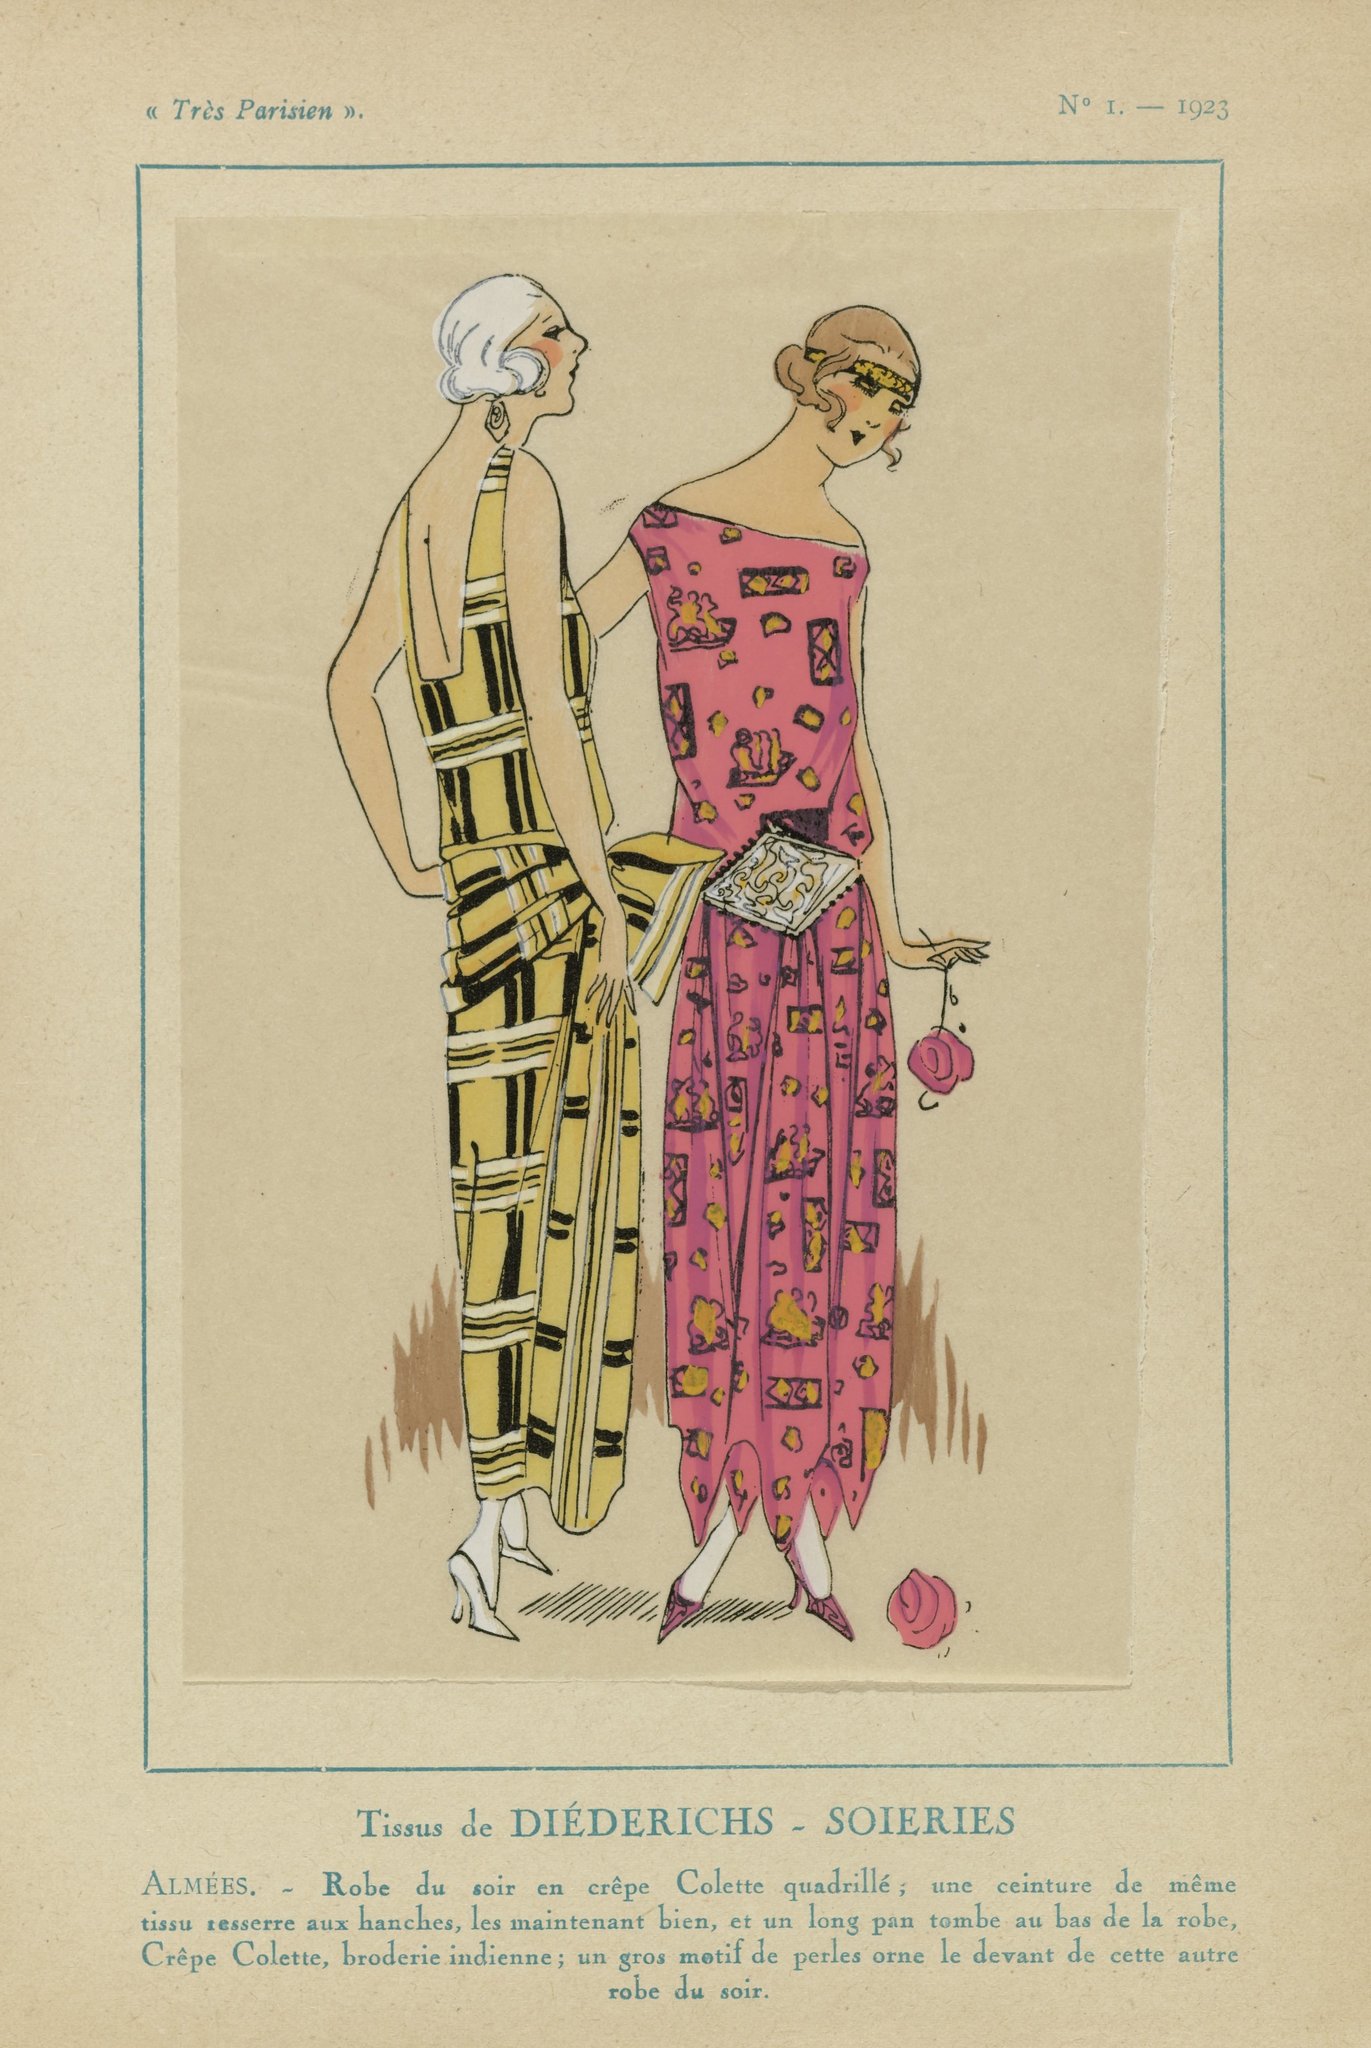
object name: fashion print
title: Très Parisien 1923 No 1: Tissus de Diederichs - Soieries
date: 1923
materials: paper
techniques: hand coloring, letterpress printing, lithography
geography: paris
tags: diadem, tiara (+ women's clothes), dress, gown: evening dress (+ women's clothes), embroidery (ornamentation) (+ women's clothes), fashion plates, belt, girdle, waistband (+ women's clothes)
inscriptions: caption: ‘Tissus de DIÉDERICHS-SOIERIES / ALMÉES. - Robe du soir en crêpe Colette quadrillé, une ceinture de même tissu resserre aux hanches, les maintenant bien, et un long pan tombe au bas de la robe, Crêpe Colette, broderie indienne; un gros motif de perles orne le devant de cette autre robe du soir.’, title: ‘Très Parisien / No 1. - 1923’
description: Twee avondjaponnen van crêpe Colette. Prent uit het modetijdschrift Très Parisien (1920-1936).